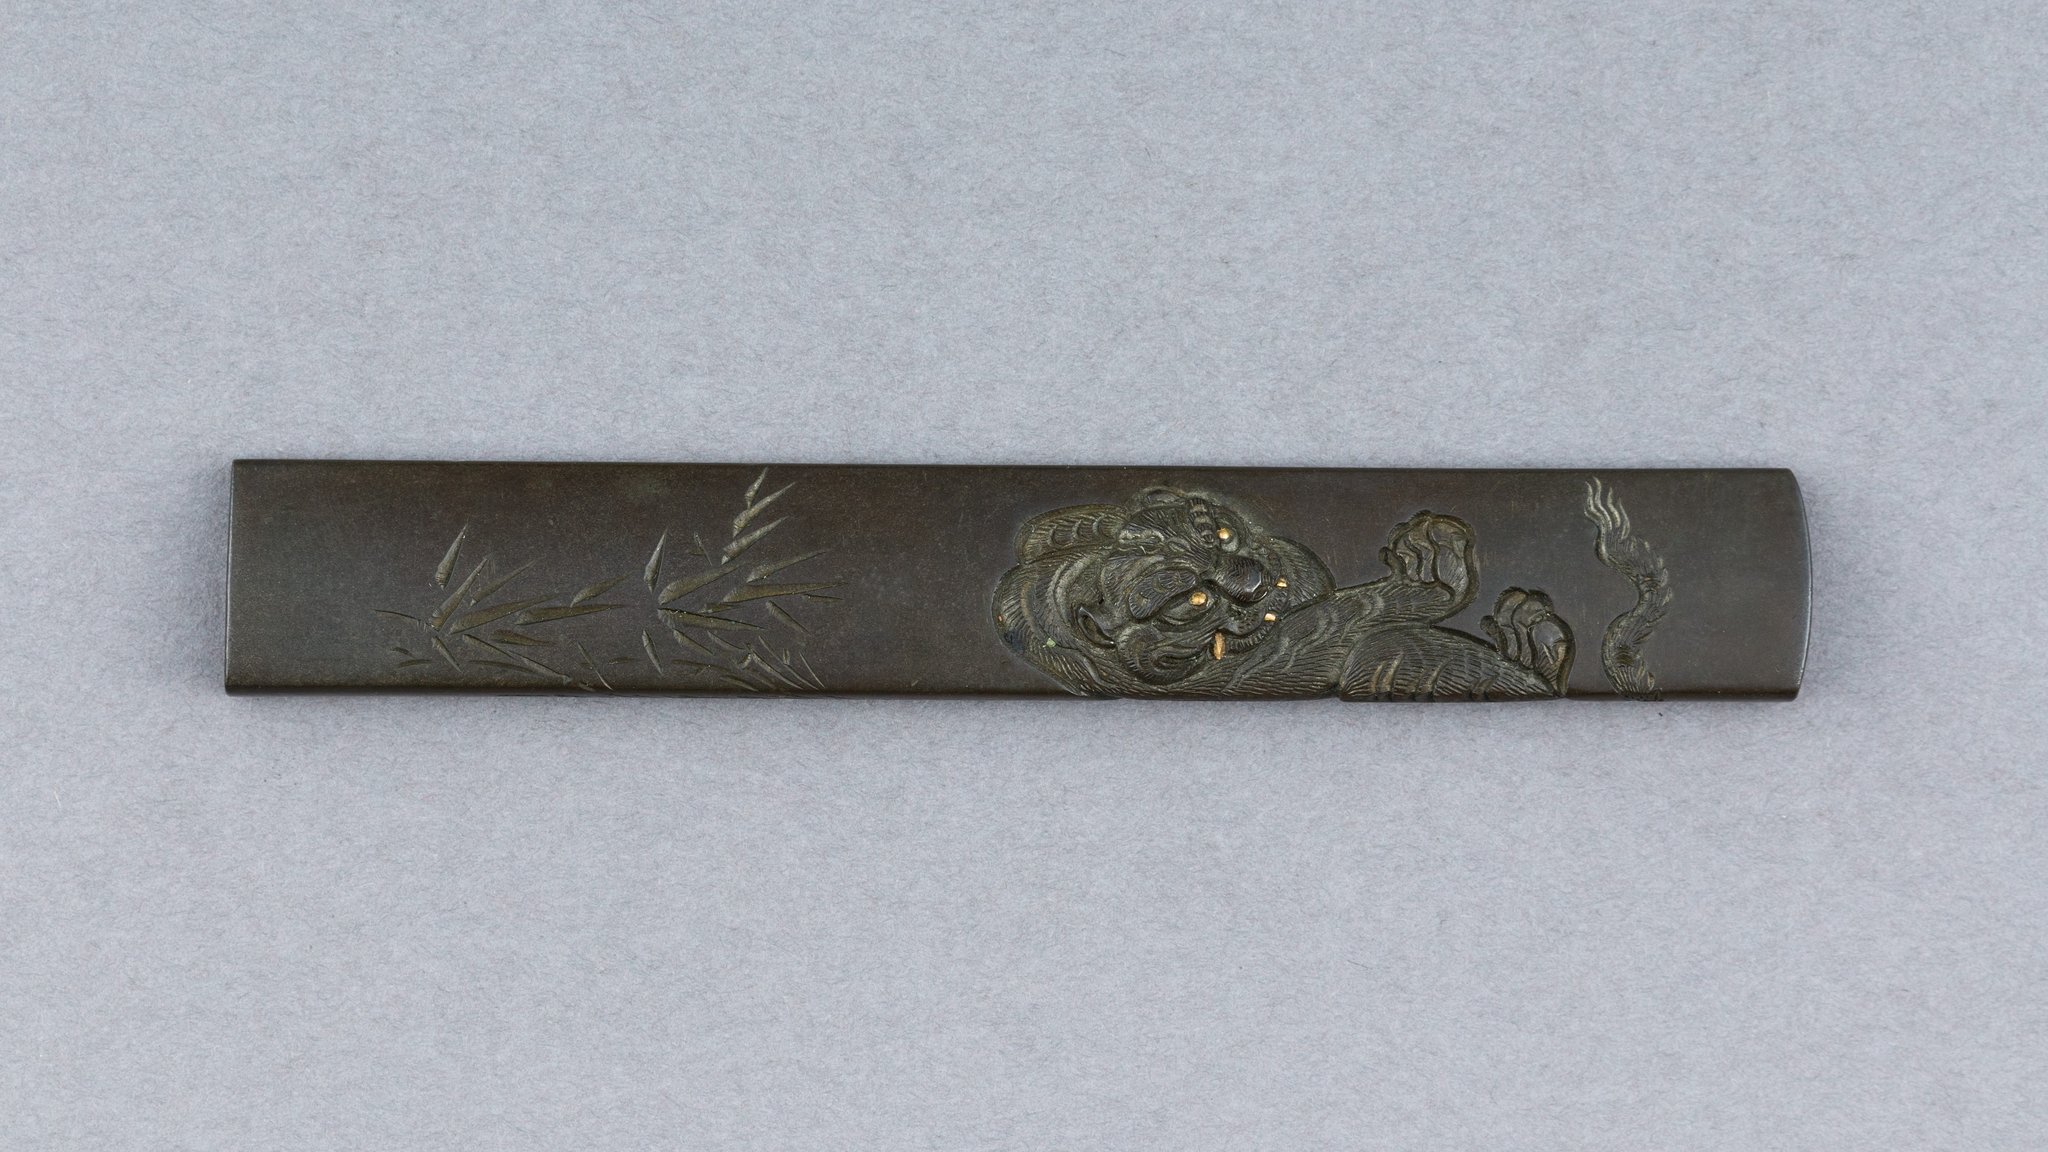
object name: knife handle kozuka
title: Knife Handle (Kozuka)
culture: japanese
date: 1615-1868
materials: silver alloy, gold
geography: japan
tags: tigers